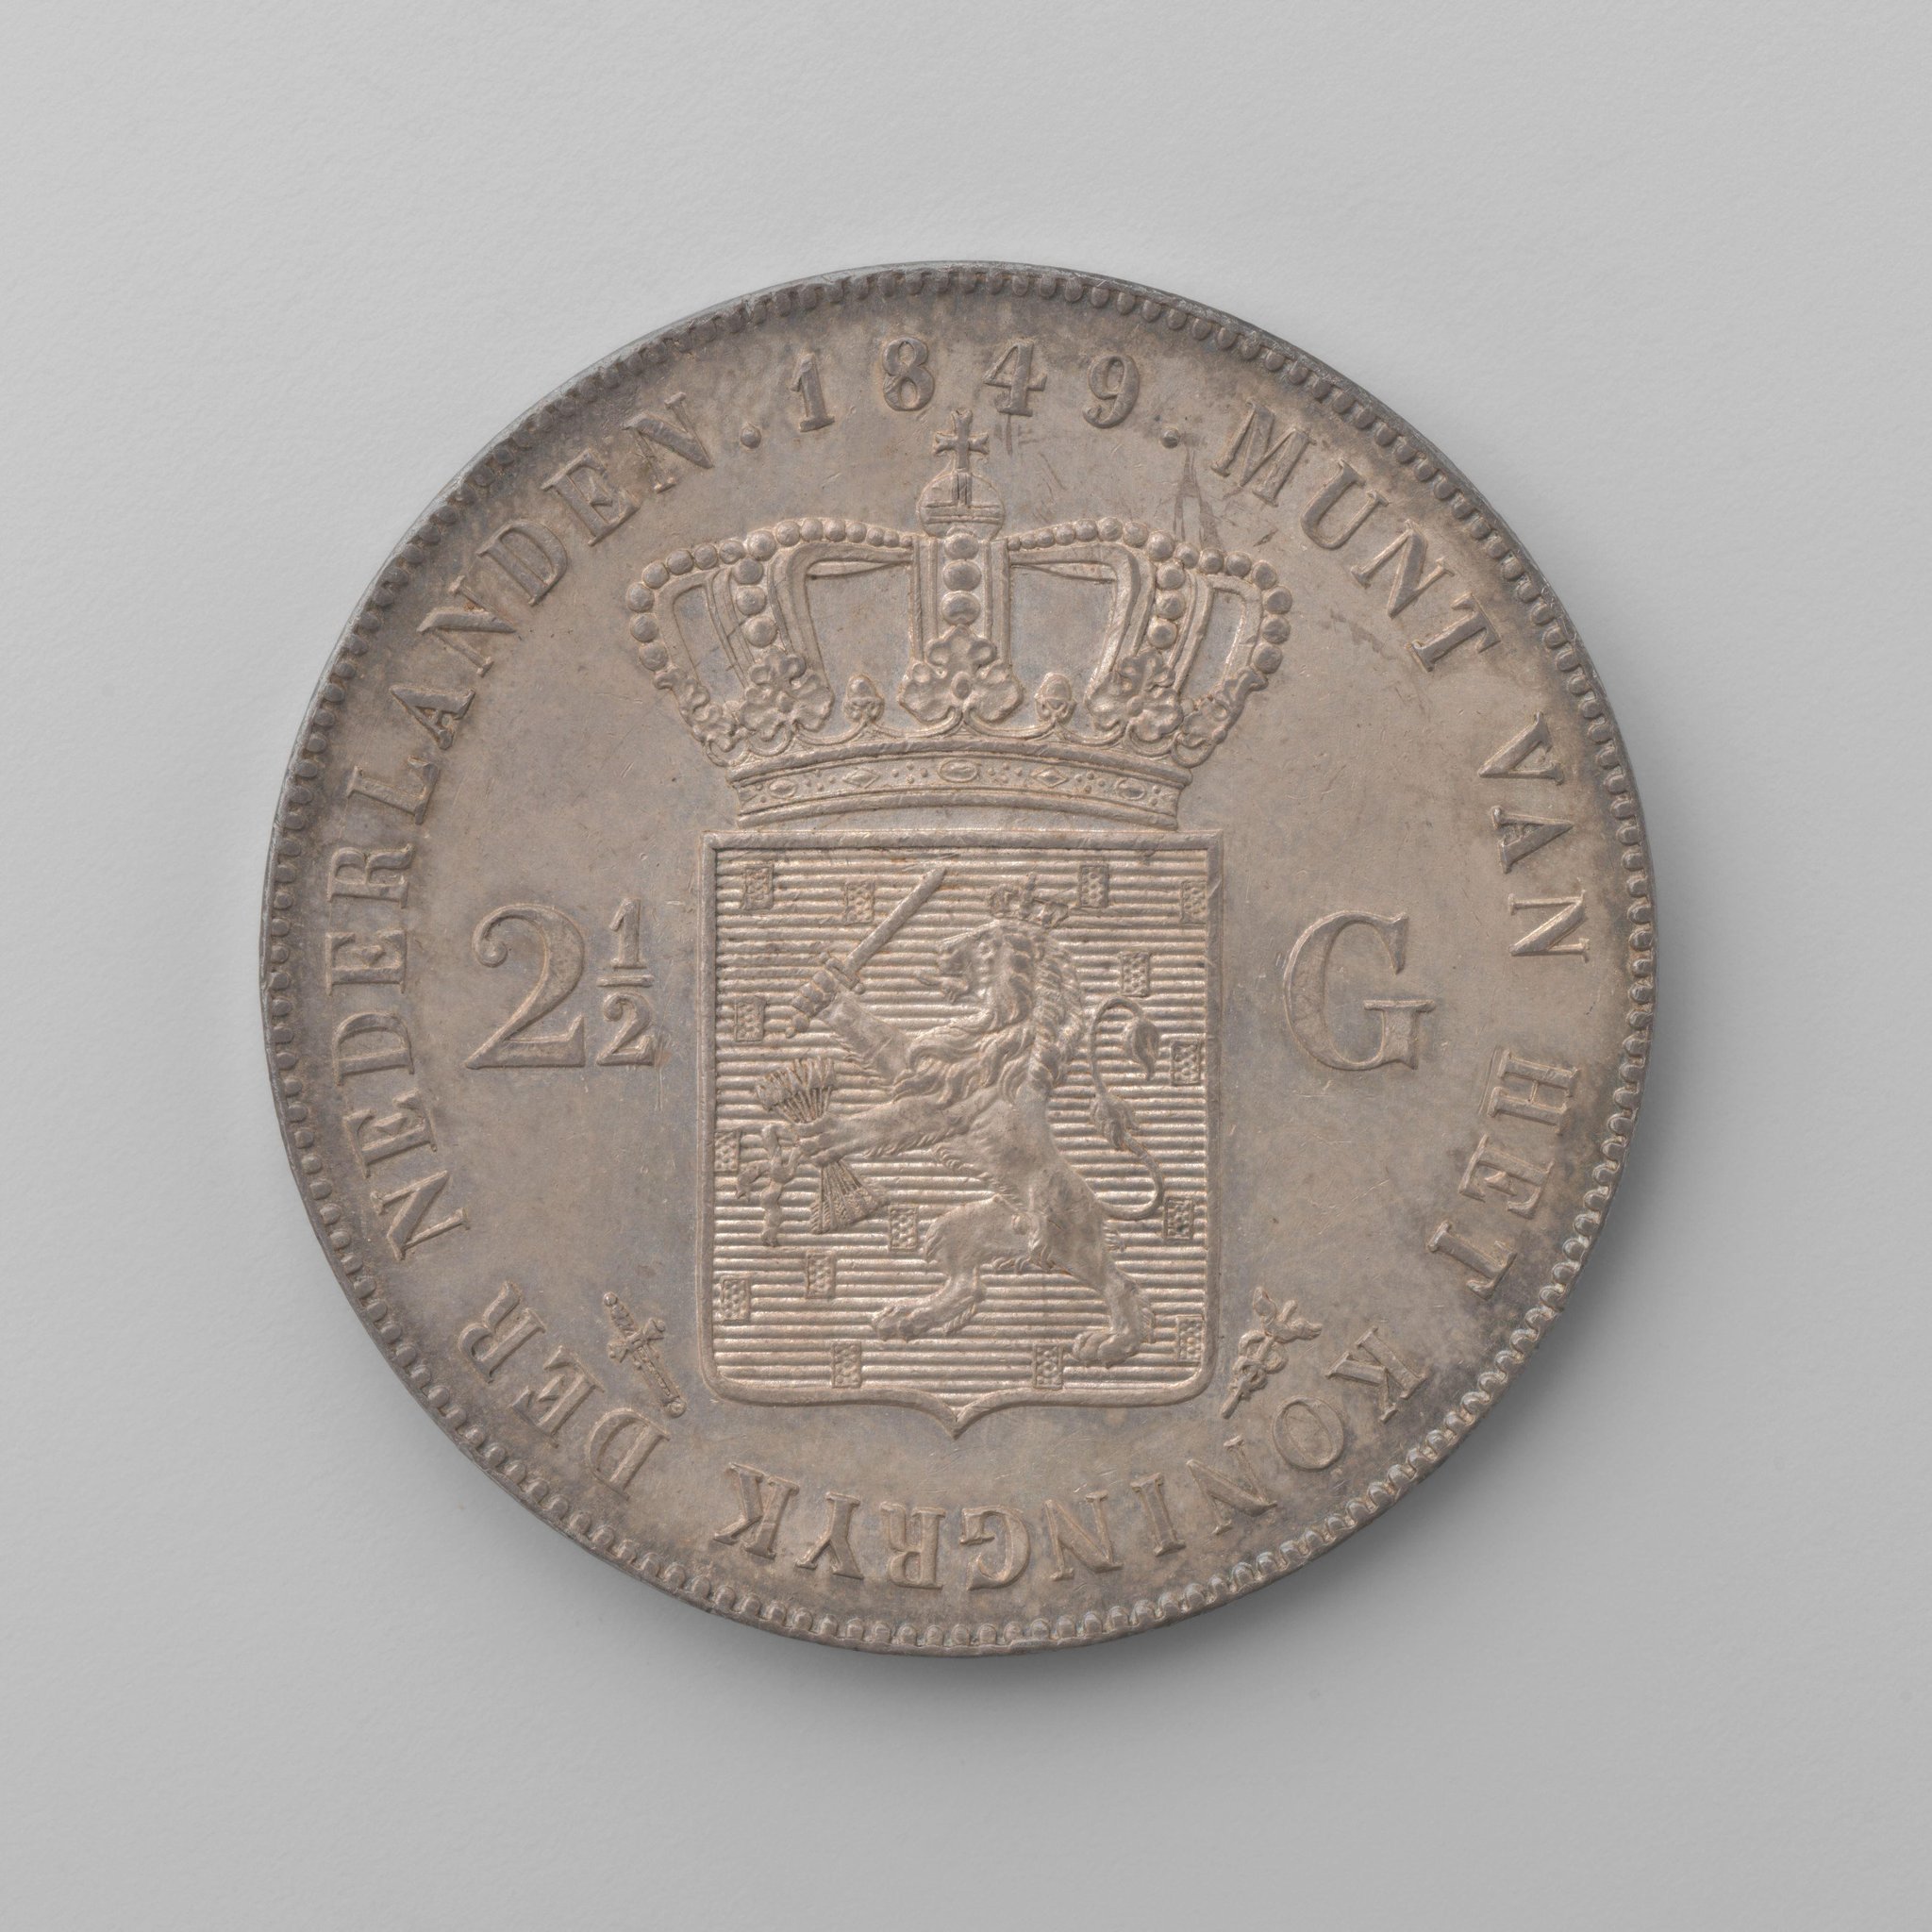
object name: coin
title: Nederlandse 2½ gulden, 1849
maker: william ii of the netherlands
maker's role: koning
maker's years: 1792-1849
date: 1849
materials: silver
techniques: striking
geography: utrecht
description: Zilveren munt. Voorzijde: borstbeeld naar links. Keerzijde: tussen waarde-aanduiding 2½ G gekroond rijkswapenschild. Jaartal boven kroon. Randschrift.